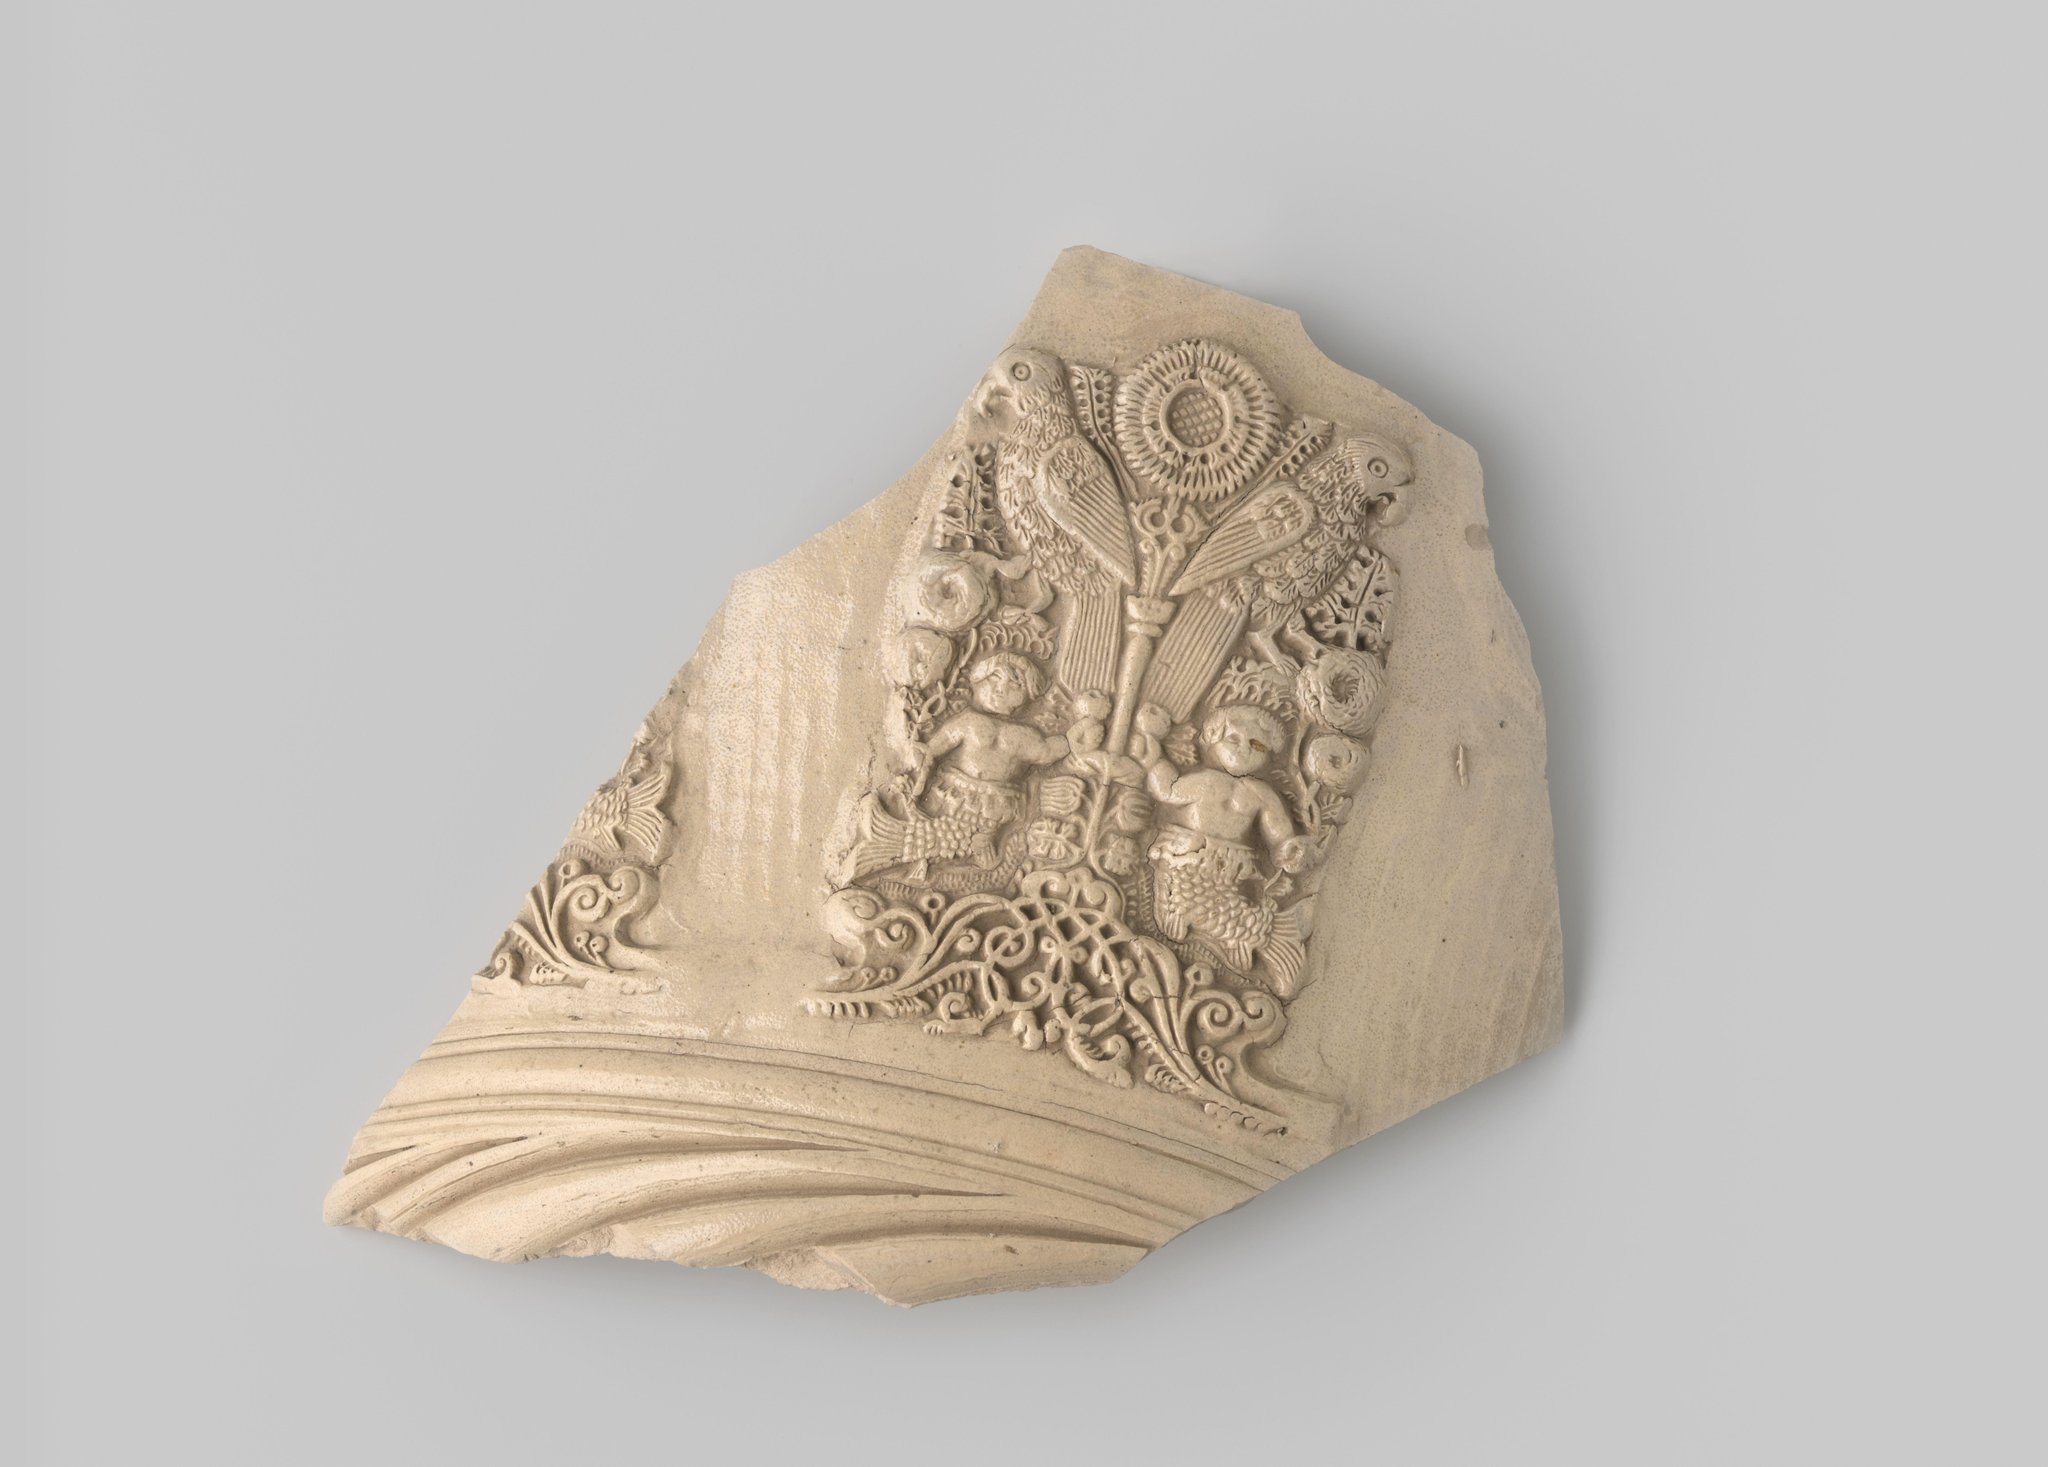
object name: fragment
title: Fragment with parrots and merman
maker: Anonymous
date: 1500-1699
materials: glaze, stoneware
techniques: firing, forming, relief, turning, vitrification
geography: germany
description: Fragment van steengoed. Op de scherf in reliëf een gedrukte en opgelegd rechthoekig vak met een symmetrische decoratie van een bloem ontspringend uit krulwerk, vastgehouden door twee meermannen met in de andere hand een bloem waarop een grote papegaai staat.